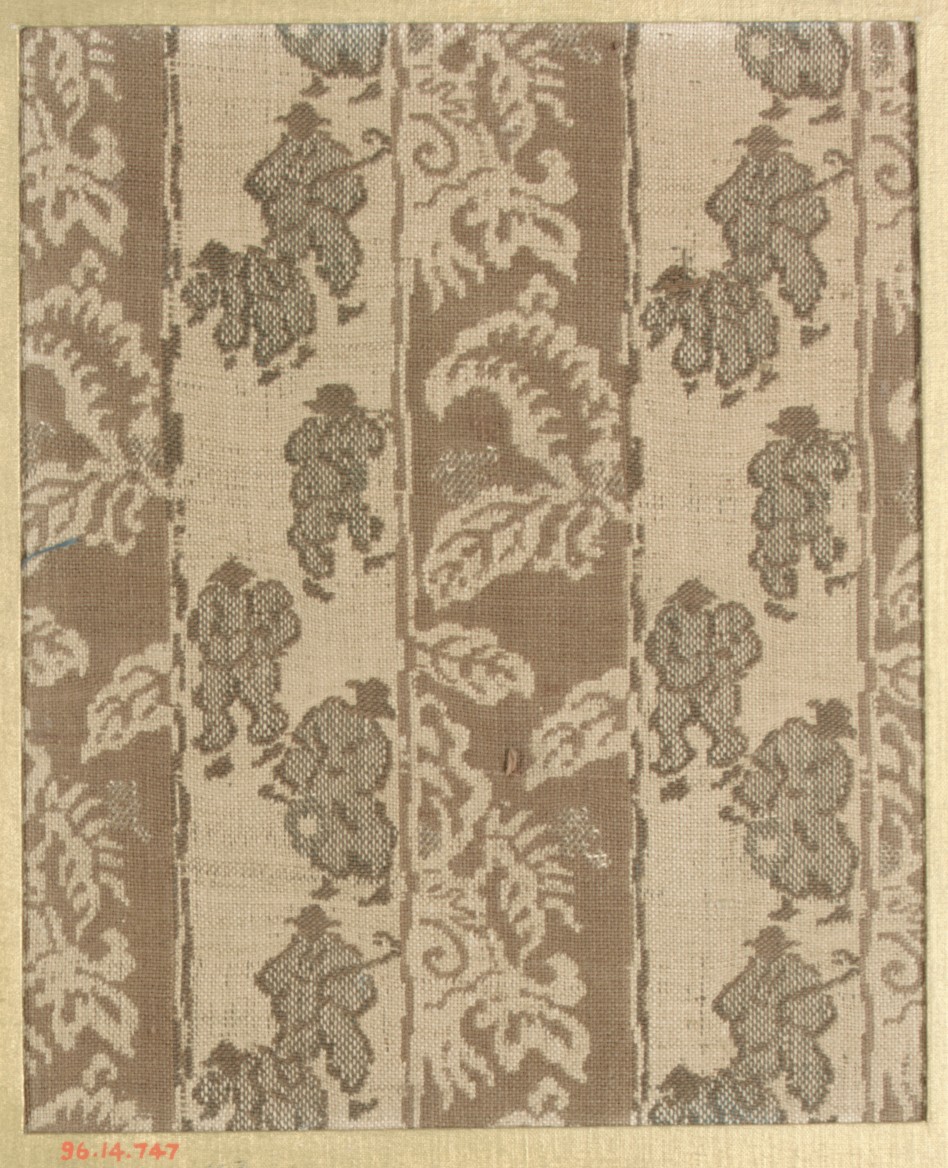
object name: piece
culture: japanese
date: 1701-1900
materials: silk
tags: human figures